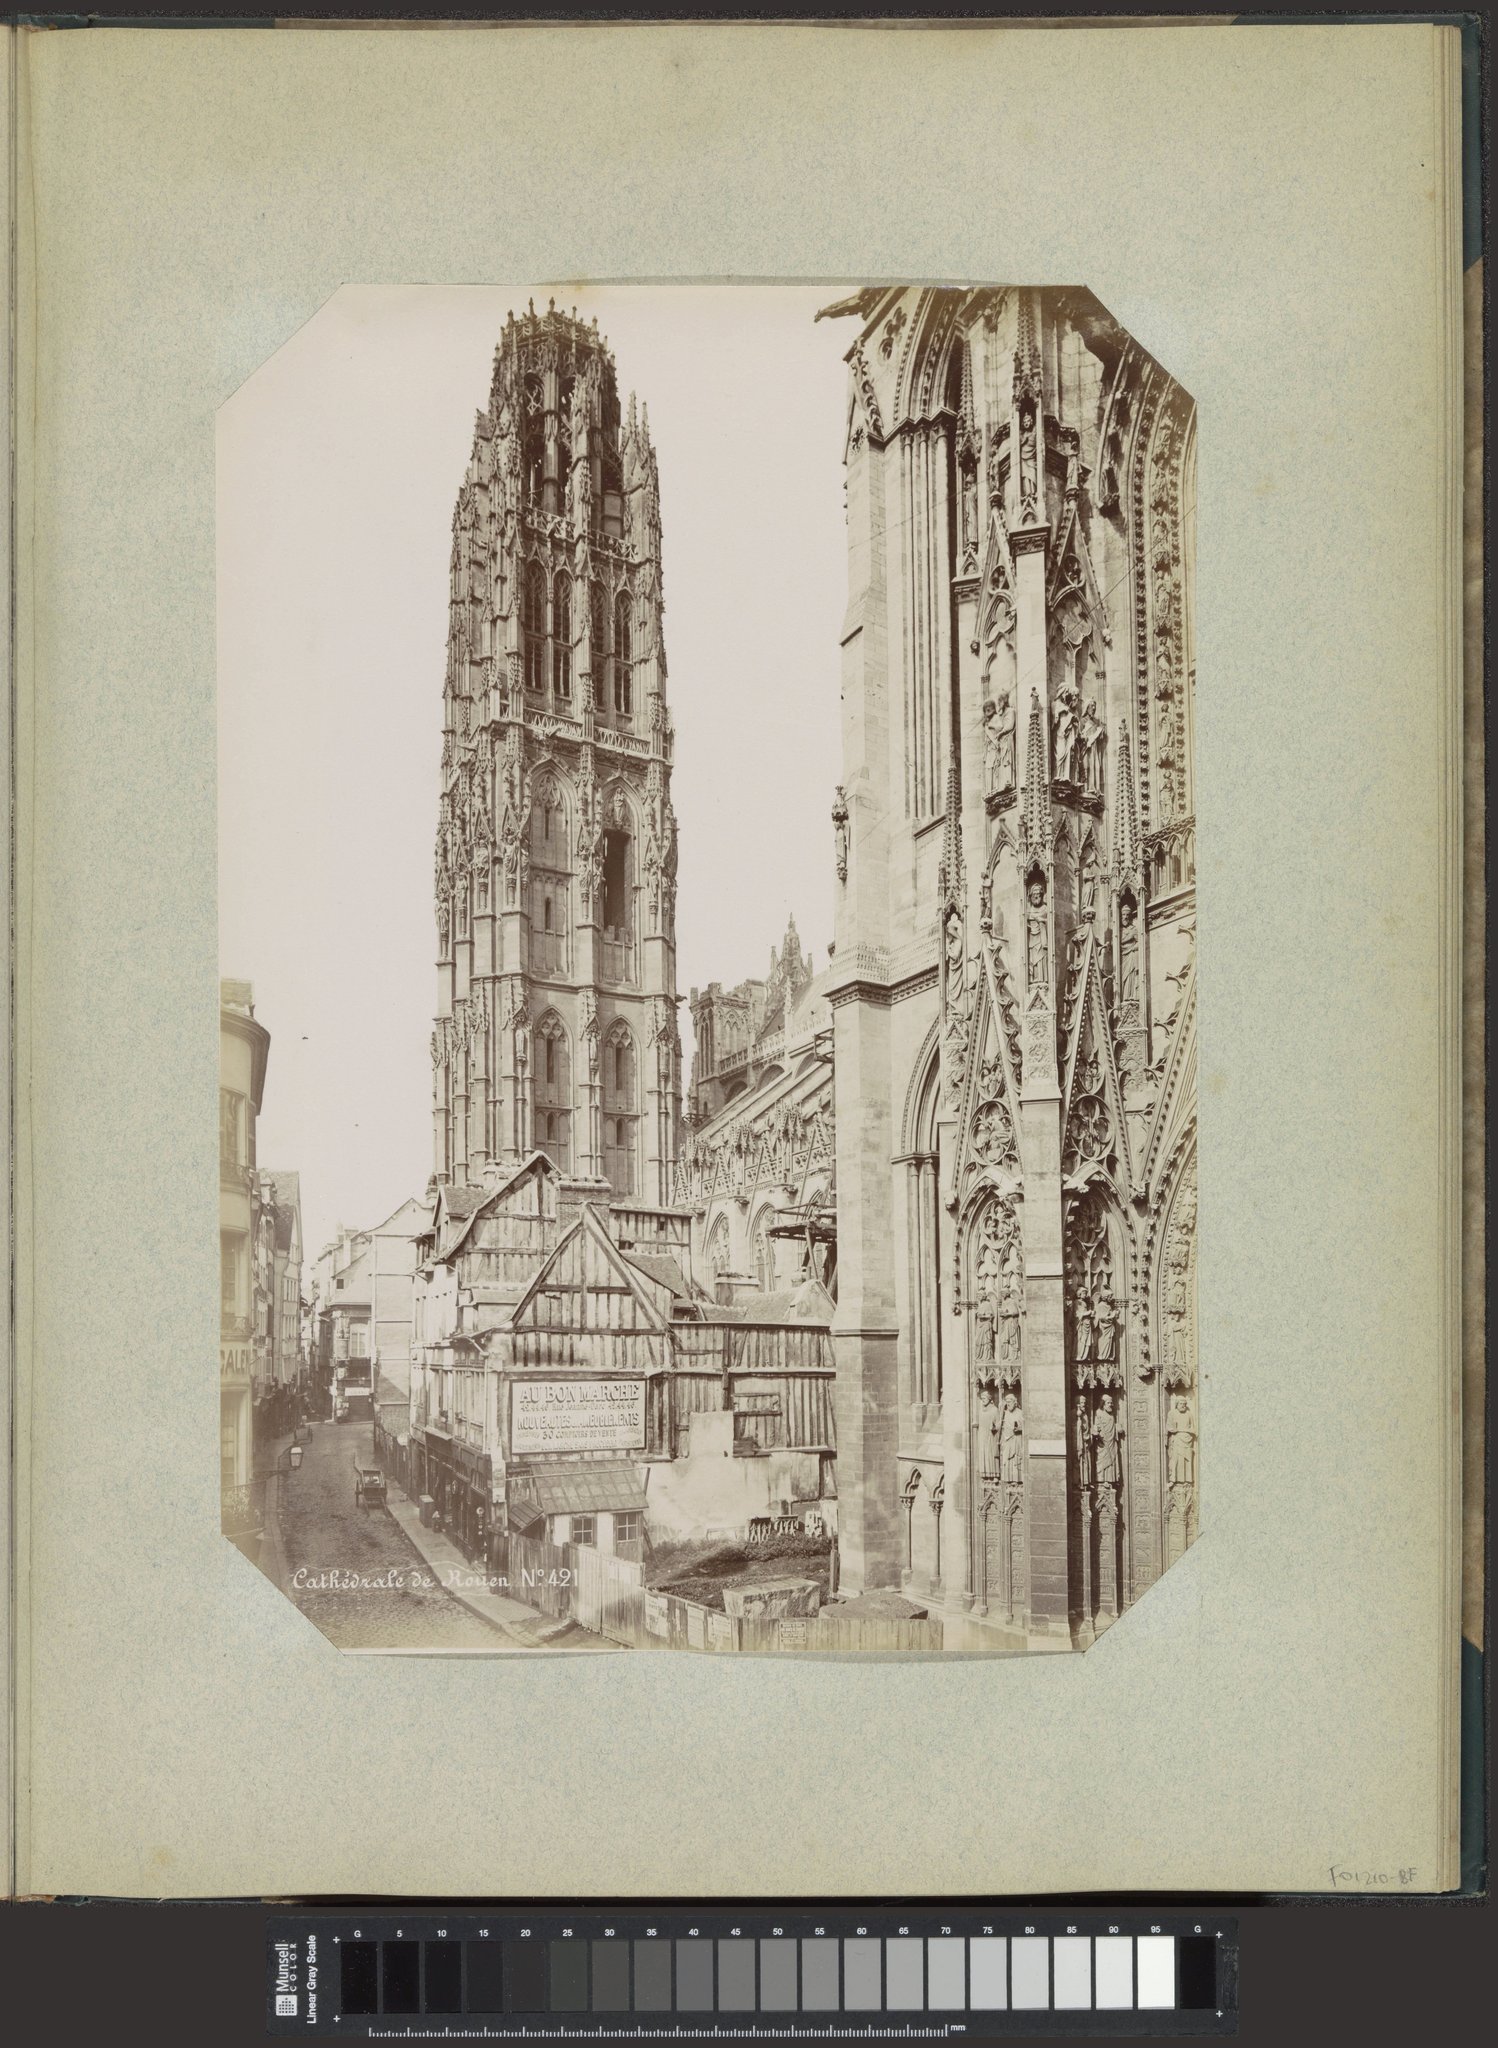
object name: photograph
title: Kathedraal van Rouen met links de Tour de Beurre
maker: séraphin-médéric mieusement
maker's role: fotograaf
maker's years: 1840-1905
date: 1880-1900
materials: photographic support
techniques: albumen print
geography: rouen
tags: advertising, church (exterior), parts of church exterior and annexes: tower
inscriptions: name: ‘Mieusement photographe’, inscription: ‘Monuments Historiques’, number: ‘421’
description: Onderdeel van Fotoalbum met opnames van monumenten in Frankrijk.